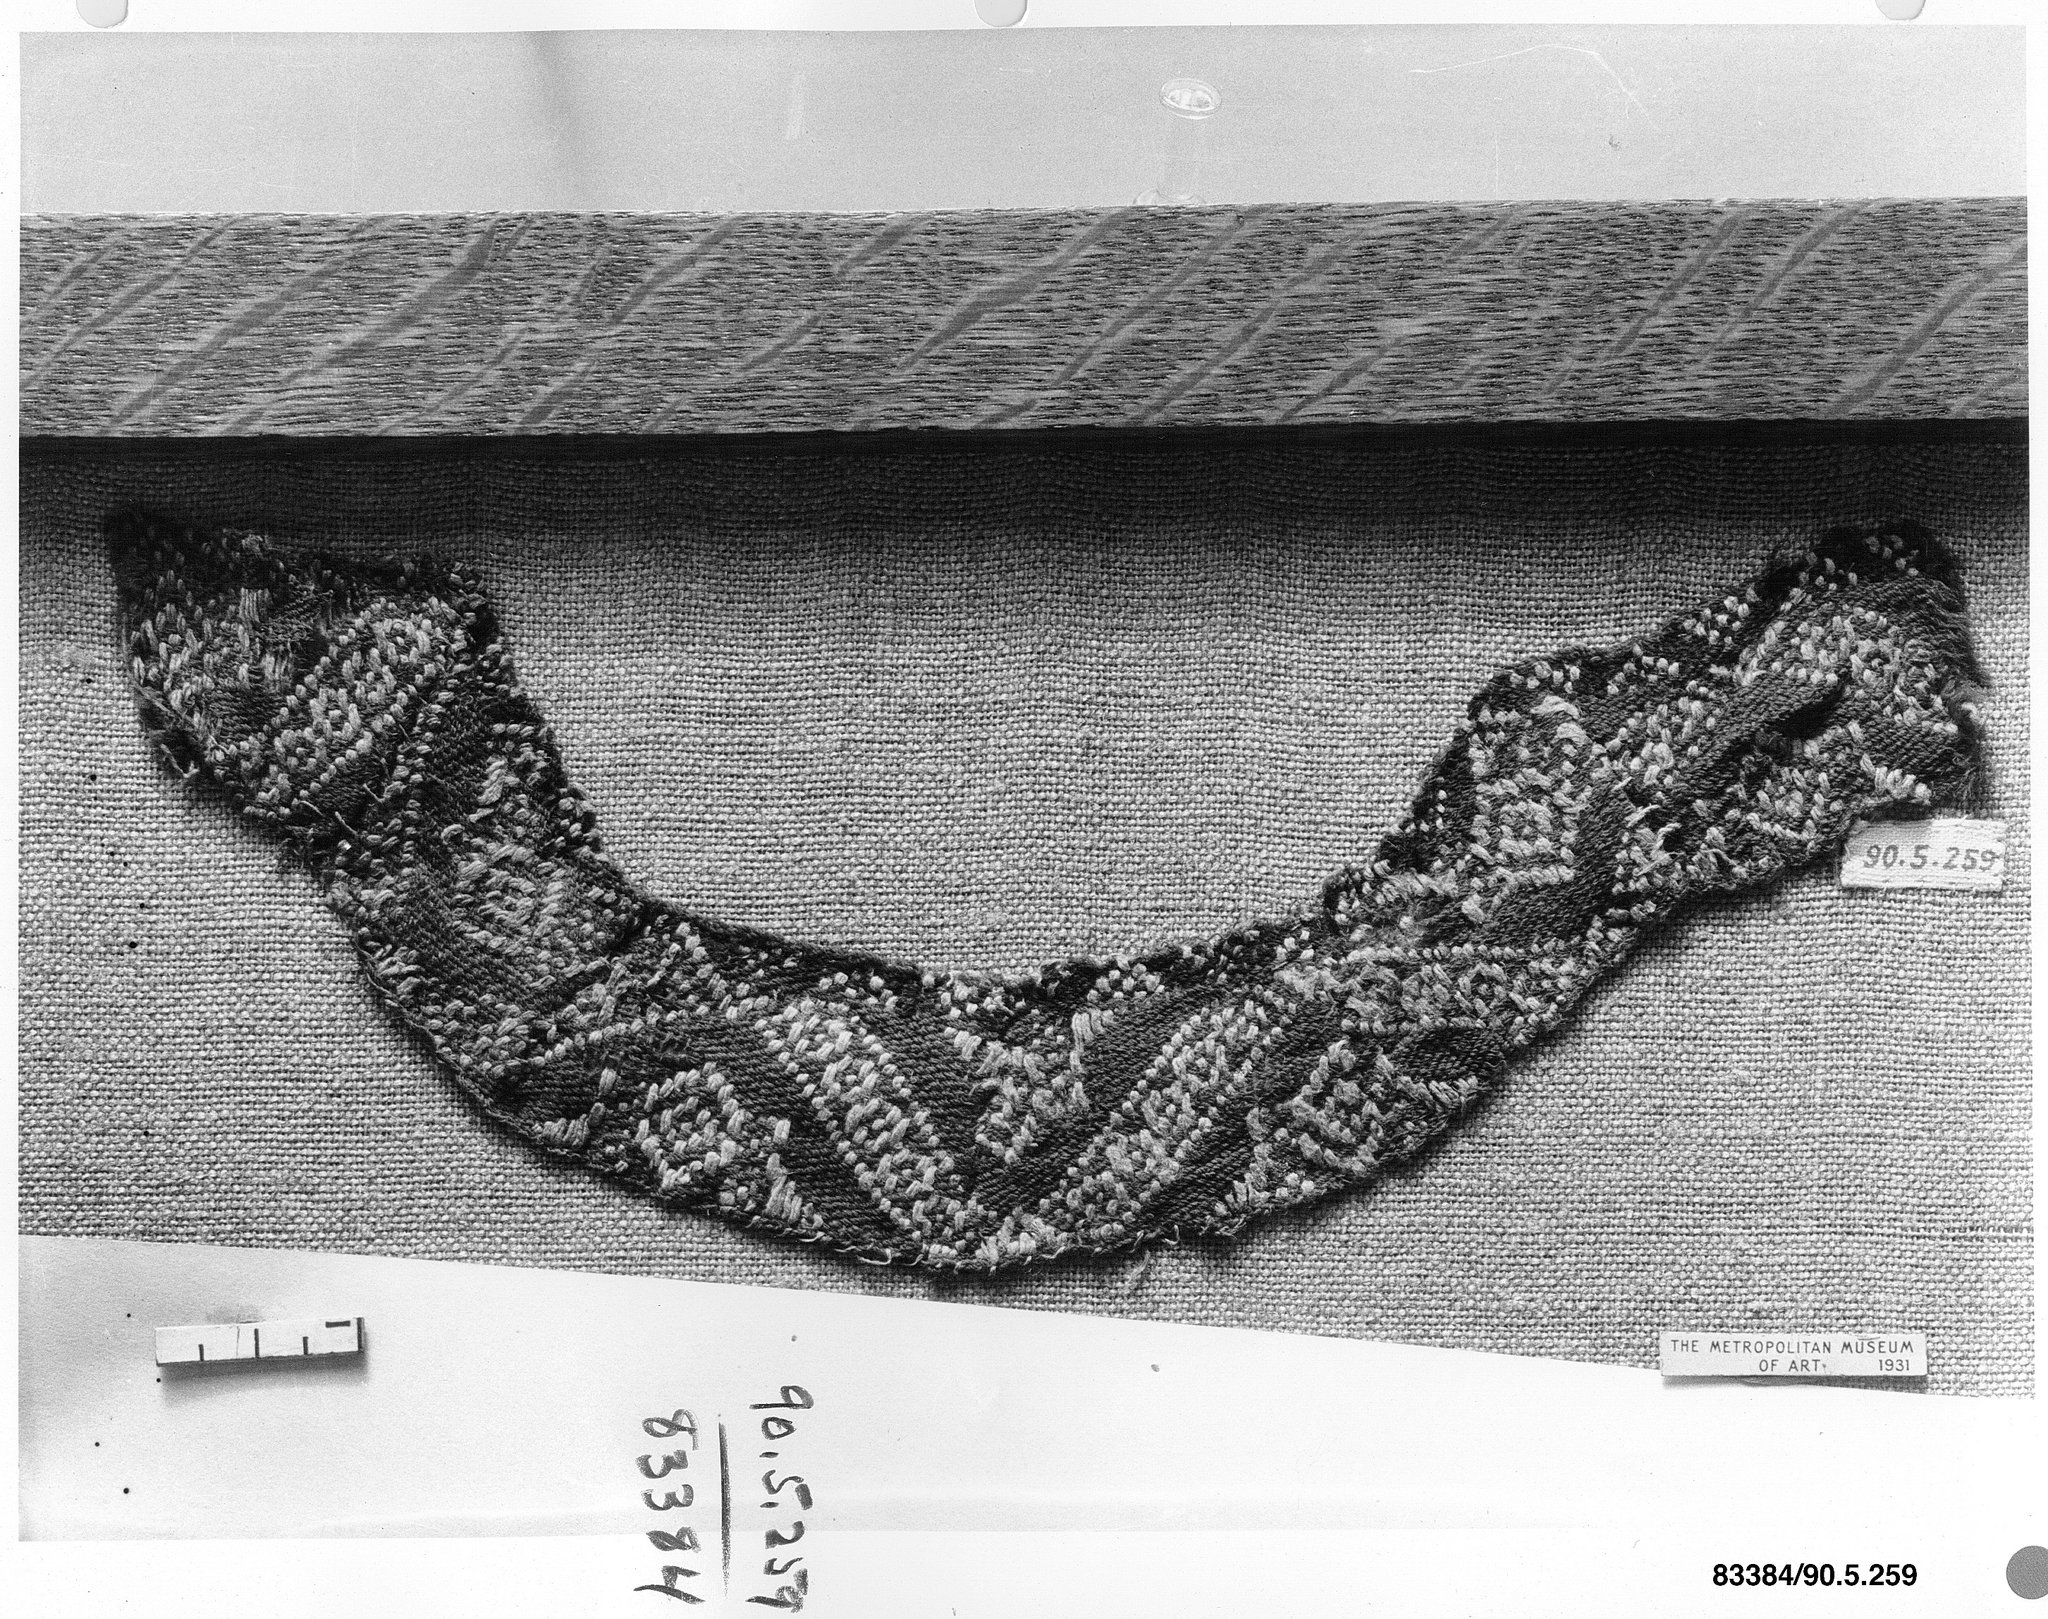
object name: textile fragment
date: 401-600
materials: linen, wool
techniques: weave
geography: egypt